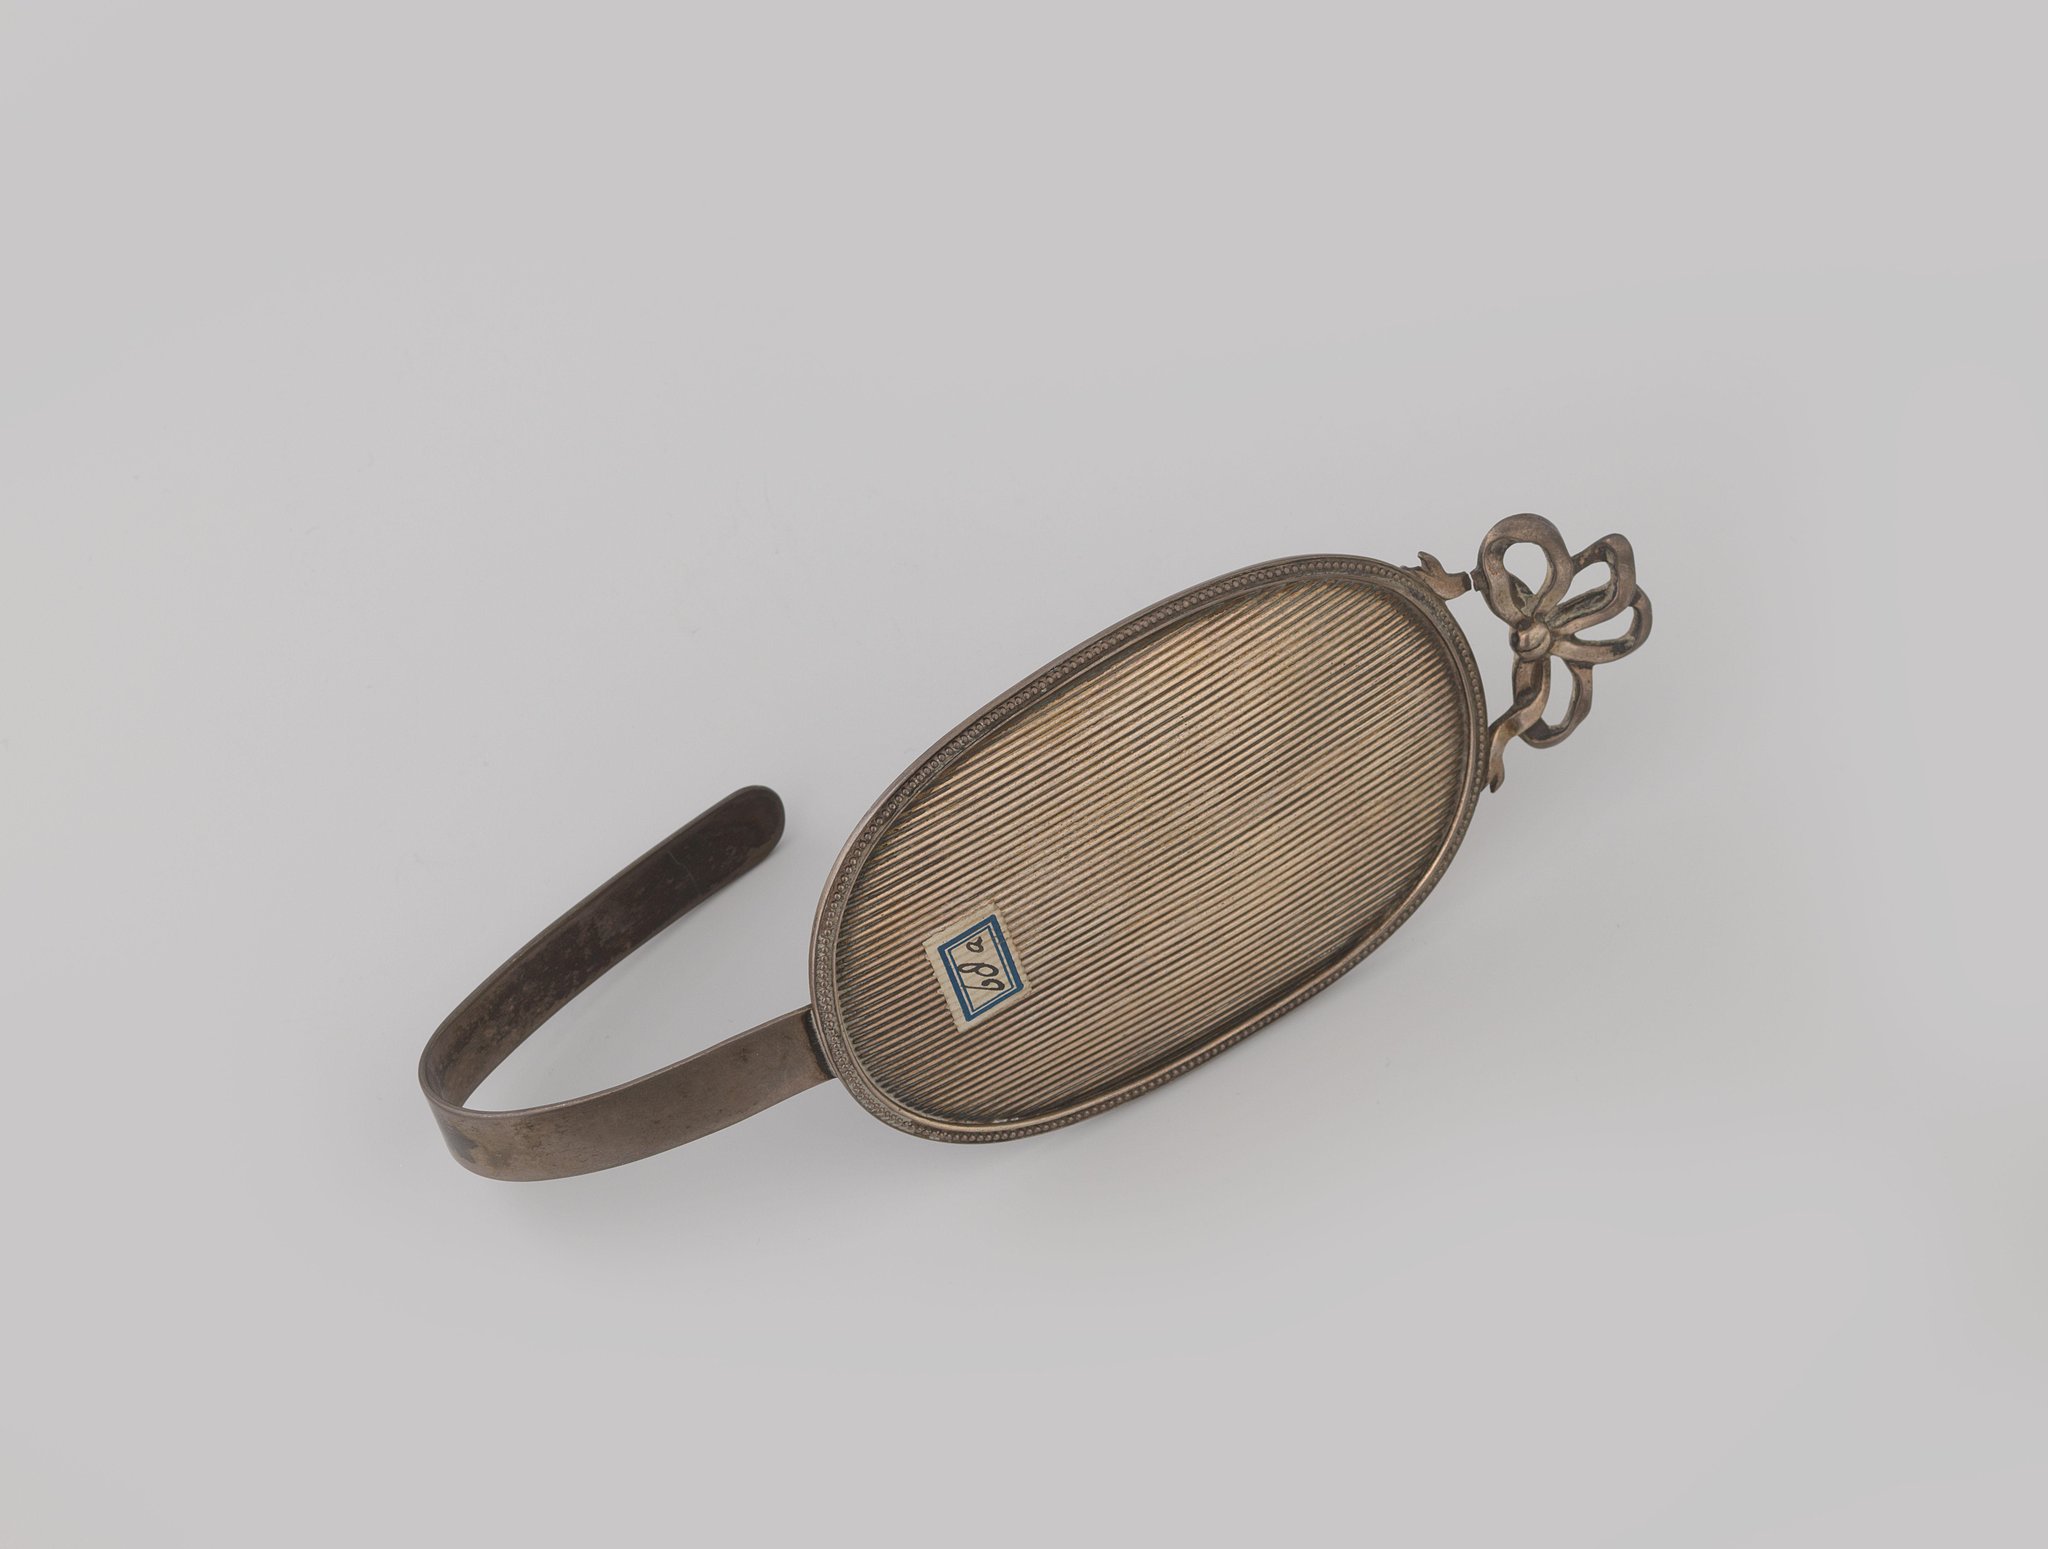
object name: curtain hook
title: Gordijnhaak van zilver met ovaal schild met parelrand en strik.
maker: Anonymous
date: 1800-1850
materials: silver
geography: netherlands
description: Gordijnhaak van zilver. Met ovaal schild met parelrandje en aan het uiteinde een strikje. Meesterteken: H.S. onder ster.